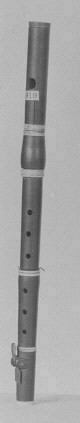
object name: transverse flute in d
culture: french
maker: gautrot aîné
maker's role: maker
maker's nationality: french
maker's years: 1870-1884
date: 1855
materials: nickel, silver, wood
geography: france